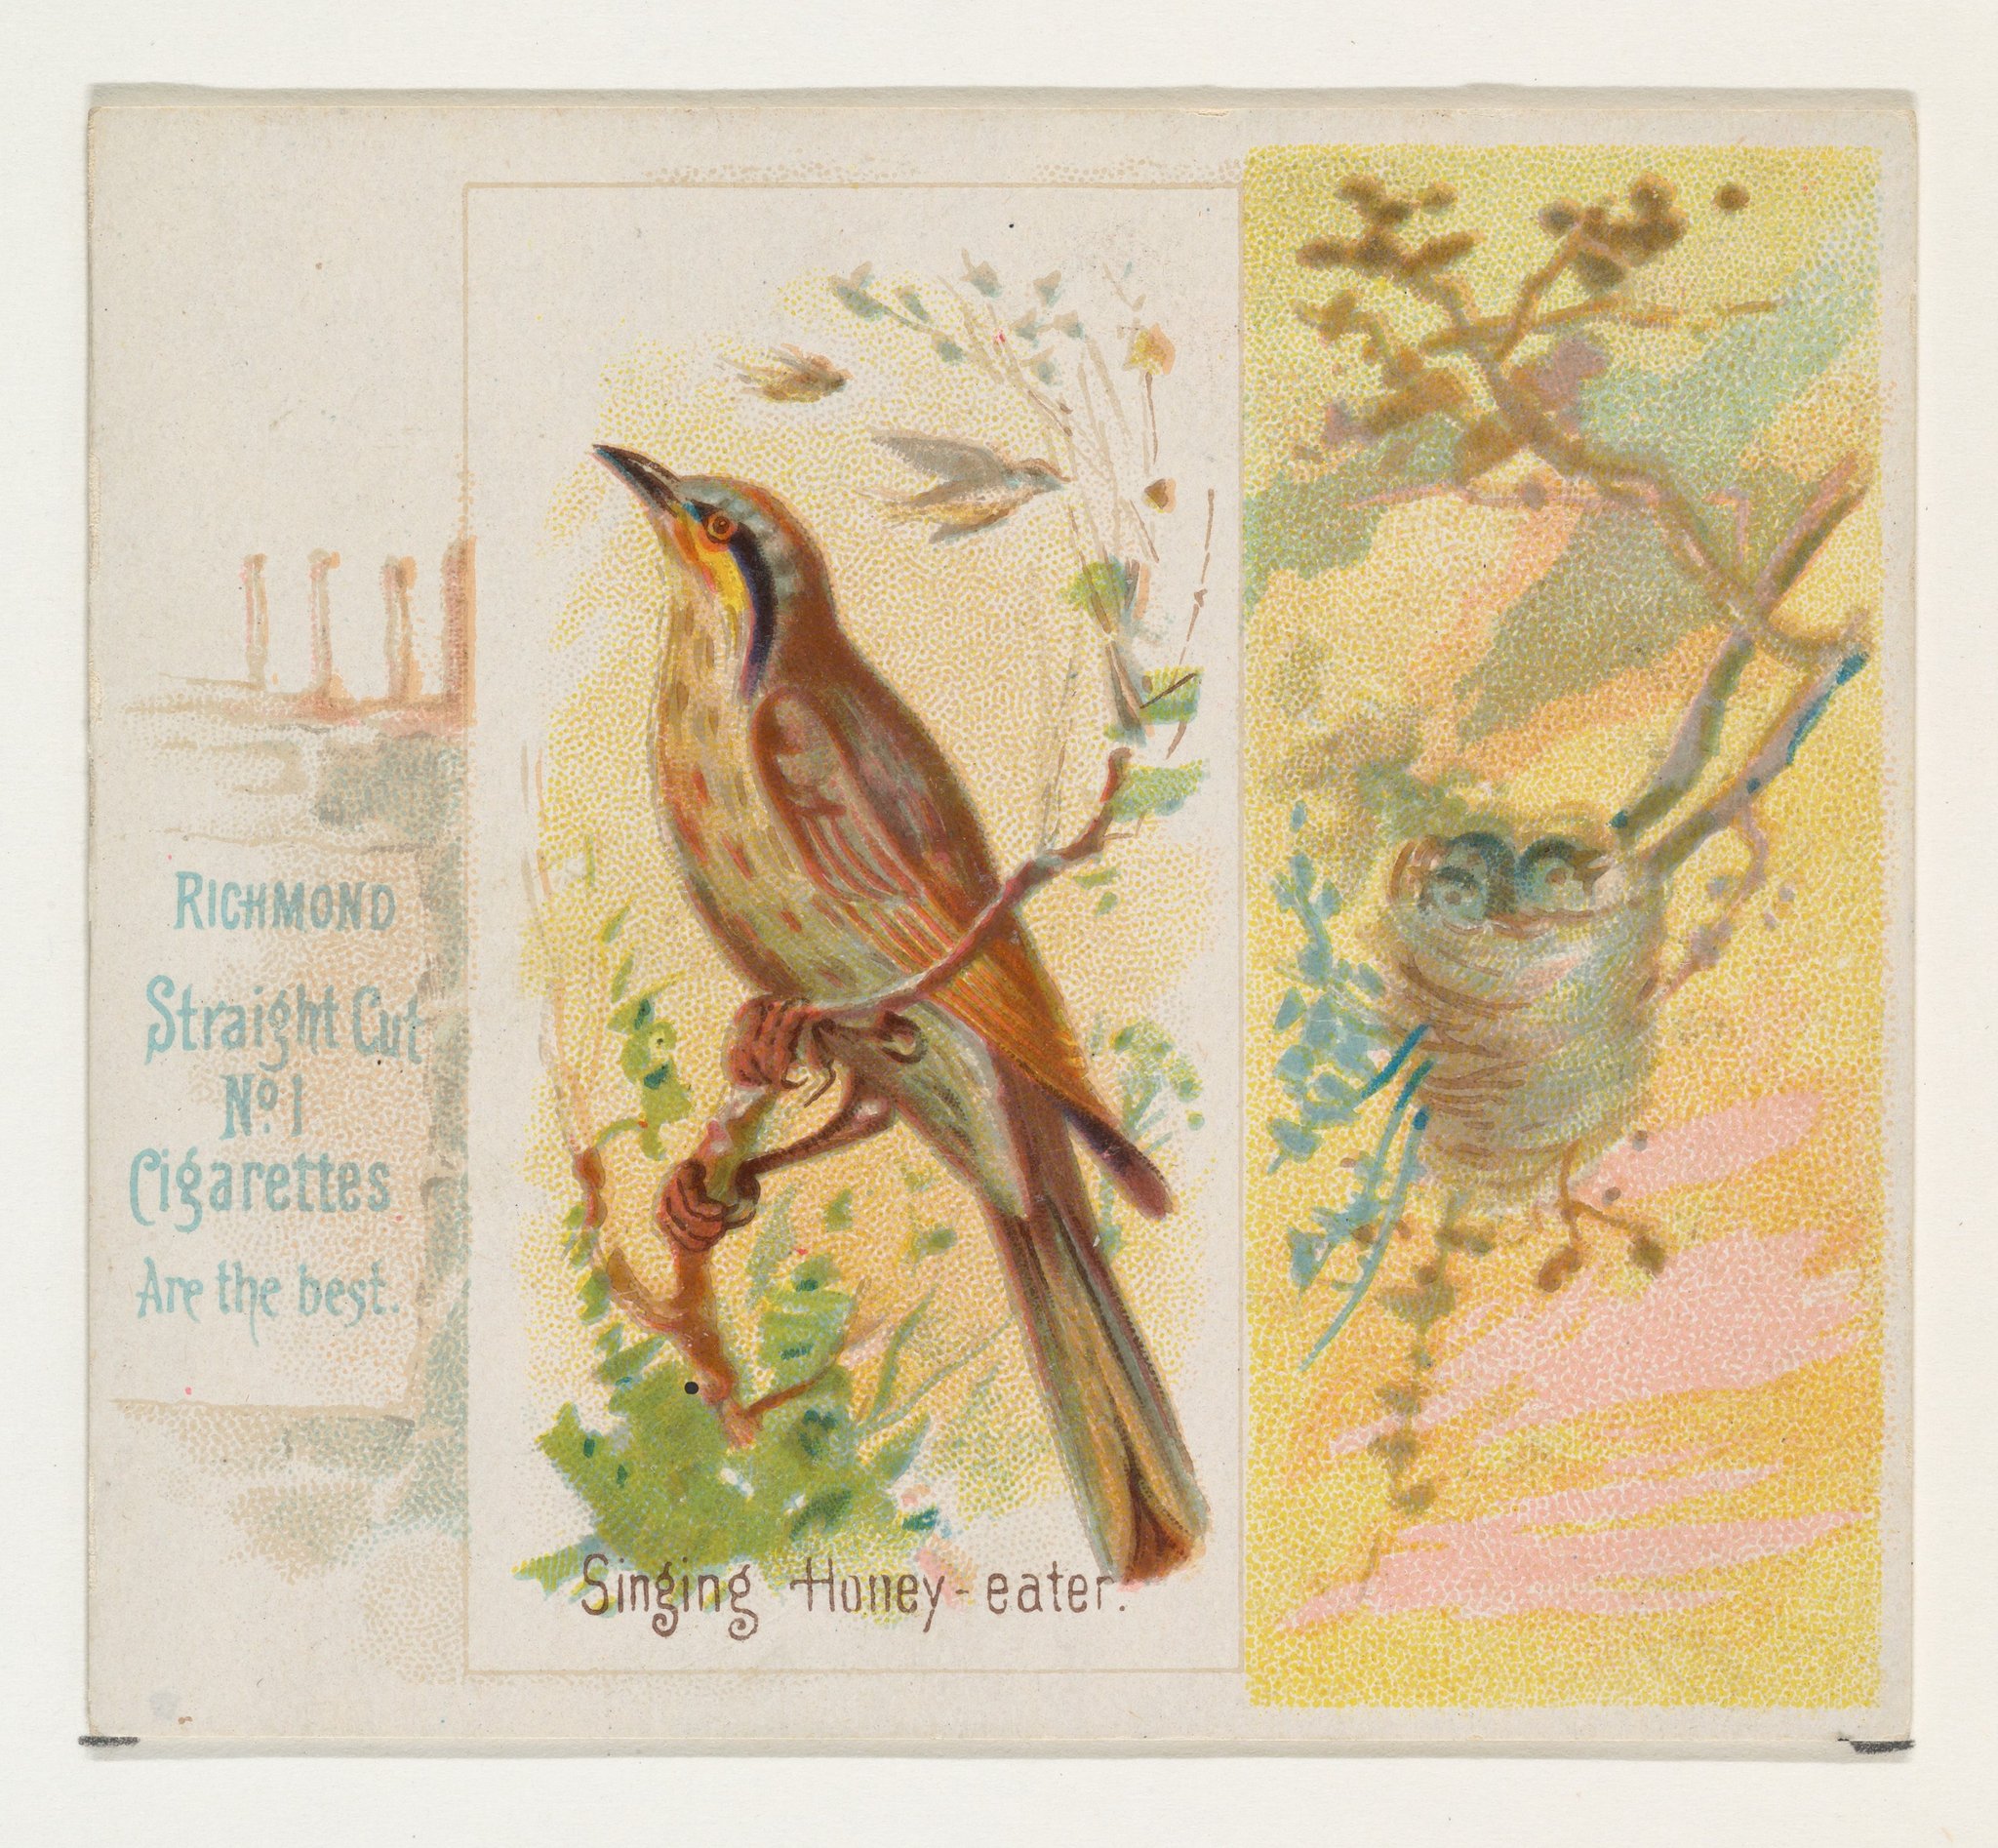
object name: print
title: Singing Honey-eater, from the Song Birds of the World series (N42) for Allen & Ginter Cigarettes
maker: allen & ginter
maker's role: publisher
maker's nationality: american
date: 1890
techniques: color lithograph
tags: birds